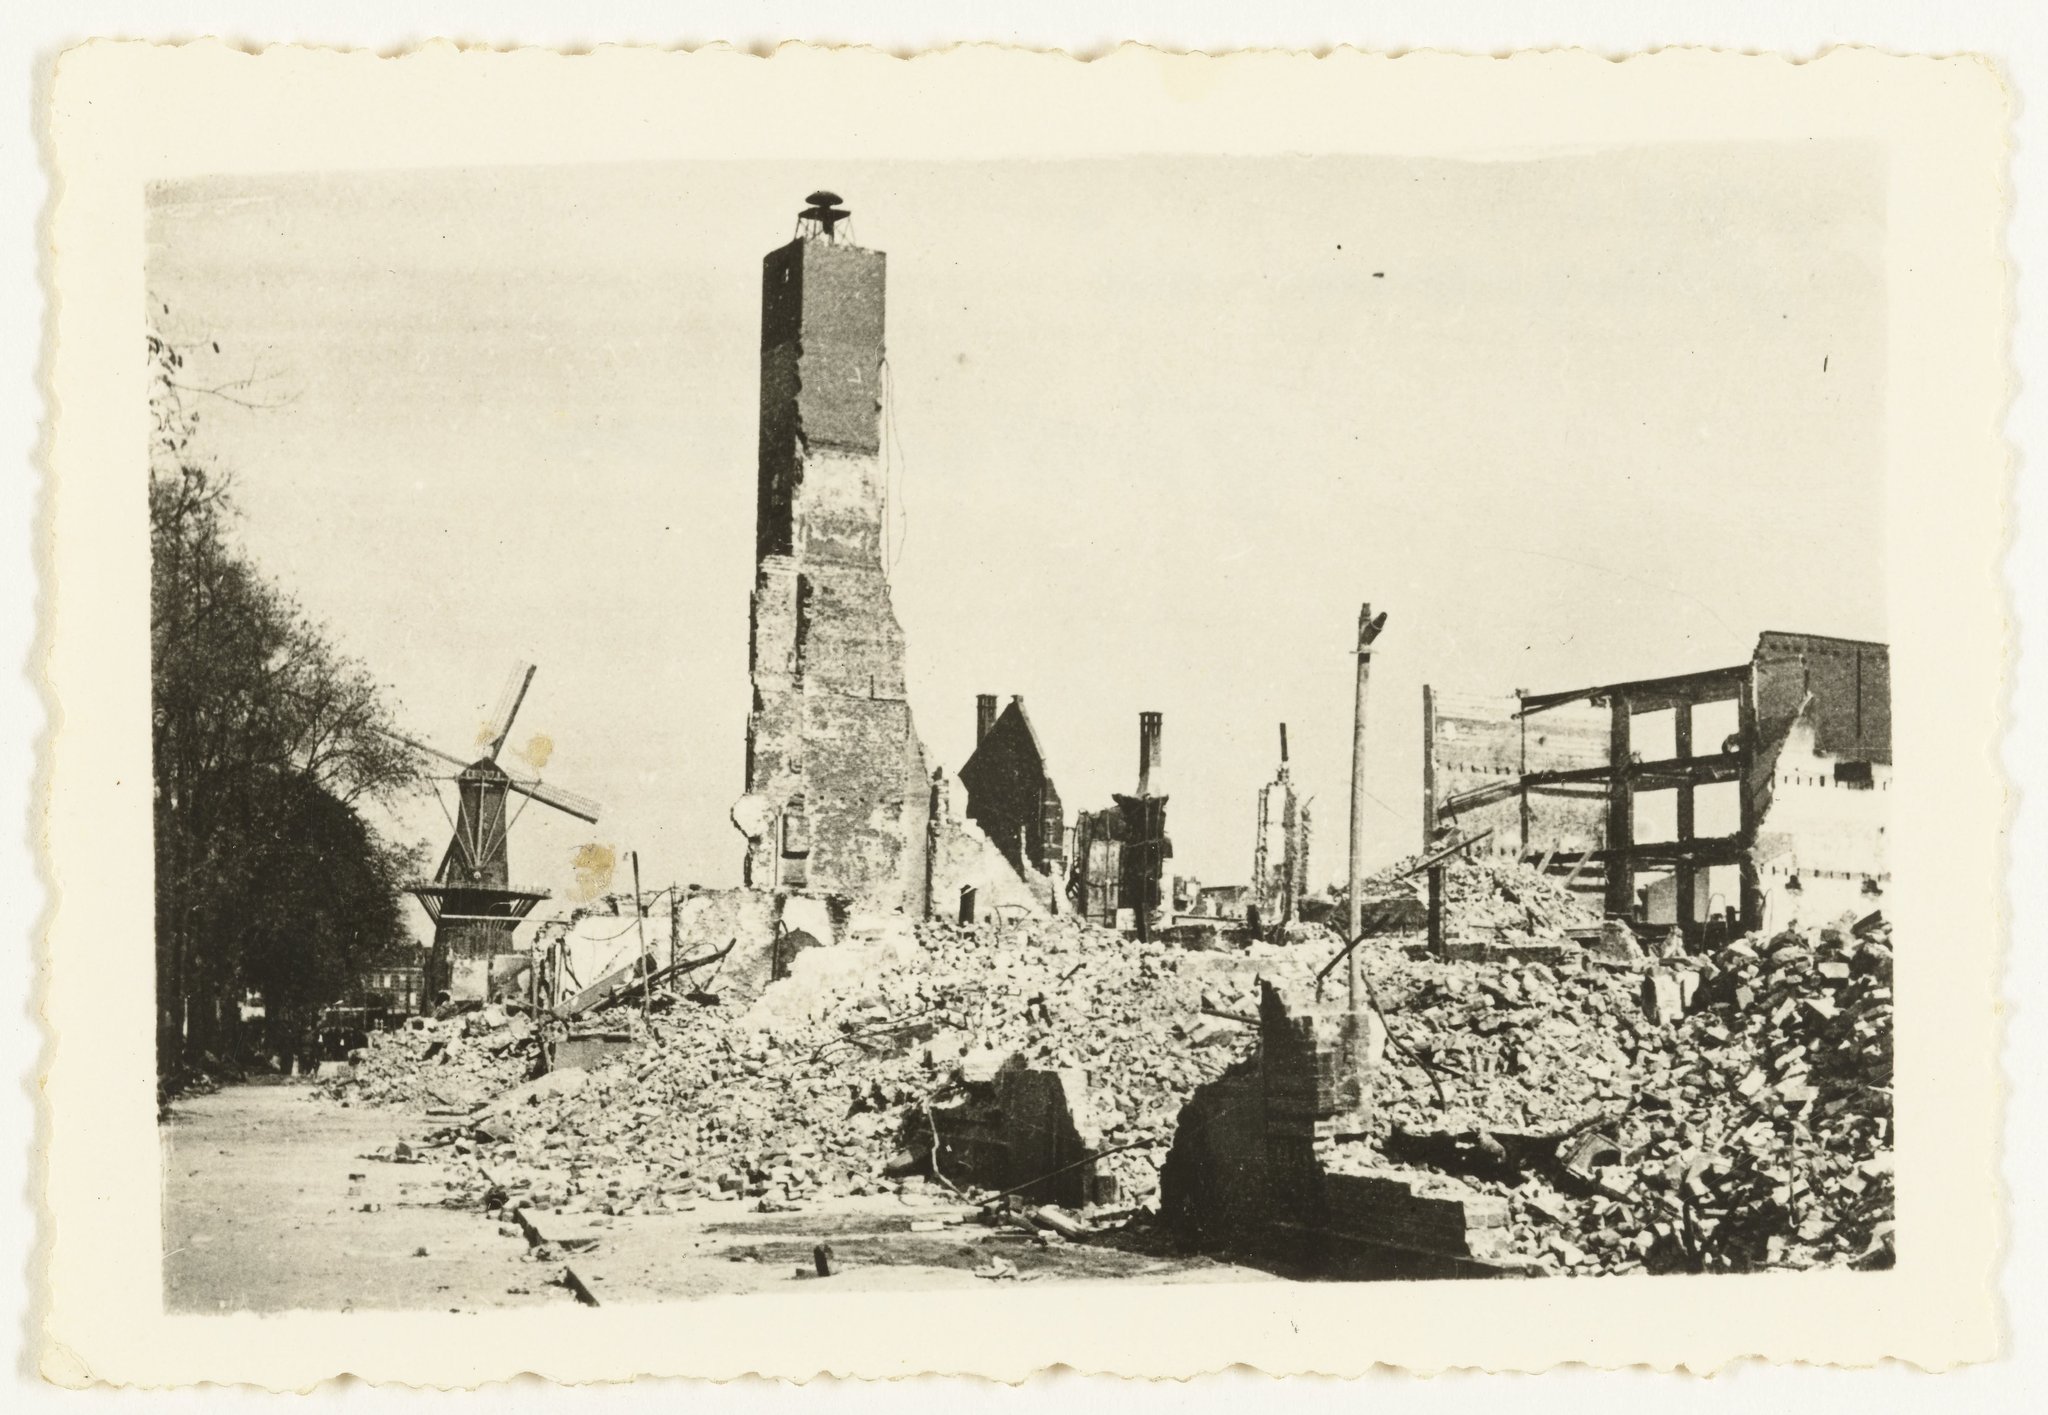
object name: photograph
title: Ruïnes in Rotterdam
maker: Anonymous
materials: photographic support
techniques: gelatin silver print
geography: rotterdam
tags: devastated, ruined place or city (~ warfare), rotterdam, rotterdam blitz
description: Ruïnes van gebouwen in Rotterdam. Links staat nog een molen overeind. (de Noord ?)